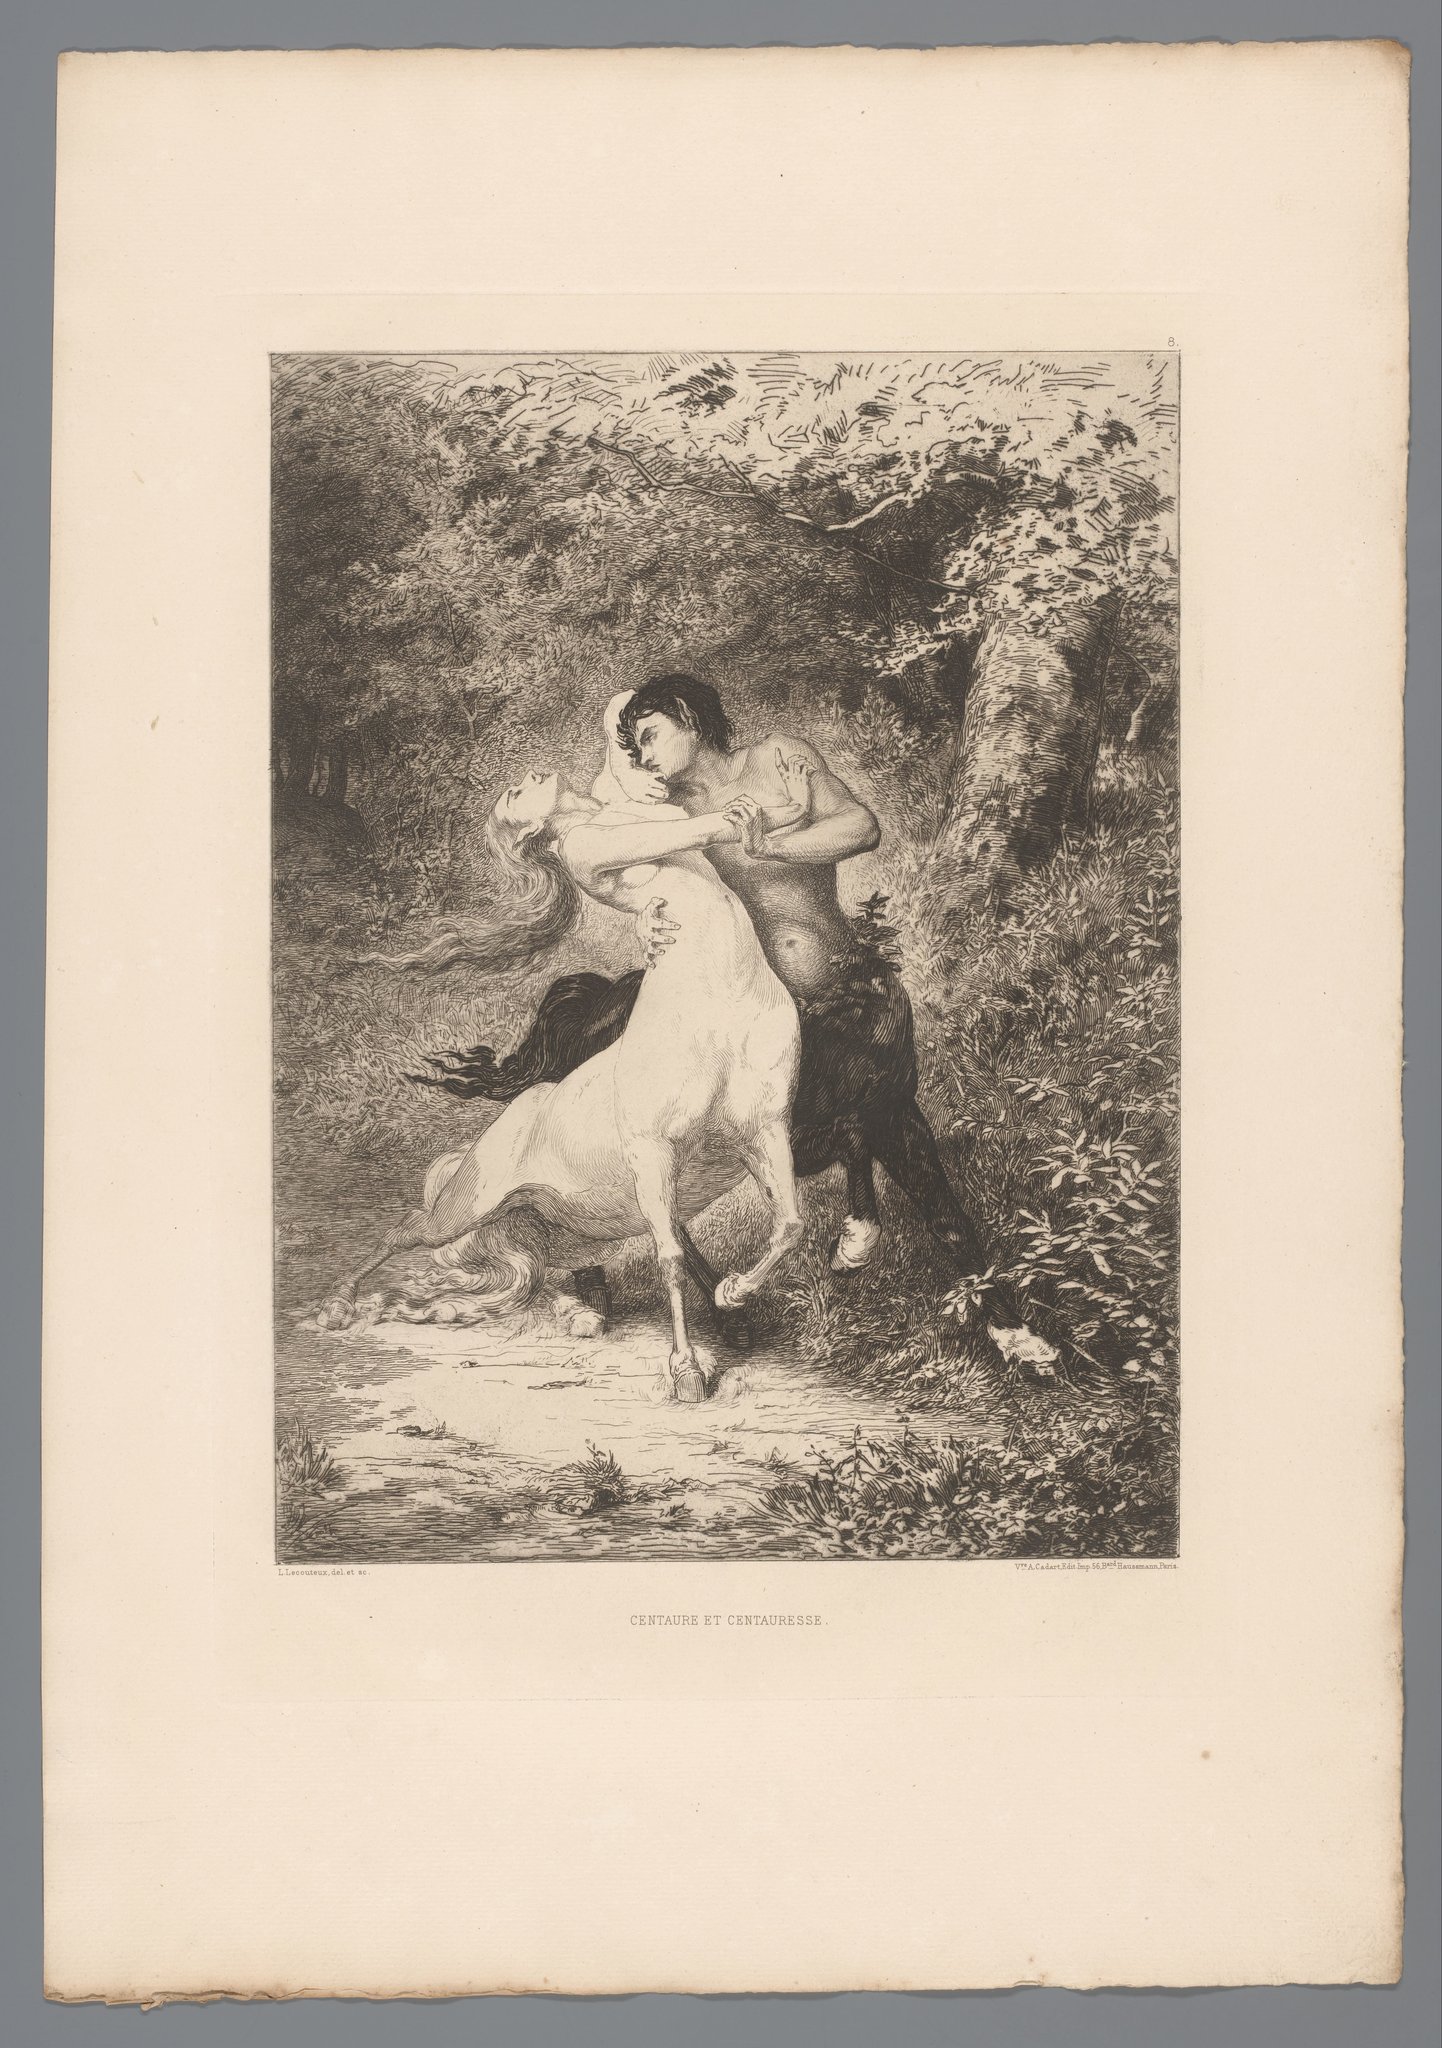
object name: print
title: L'eau-forte en 1878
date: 1878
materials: paper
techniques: drypoint, etching, intaglio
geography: paris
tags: centaurs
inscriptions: collector's mark: Lugt 2228, collector's mark: ‘AFE v S’, watermark, collector's mark: Lugt 2760